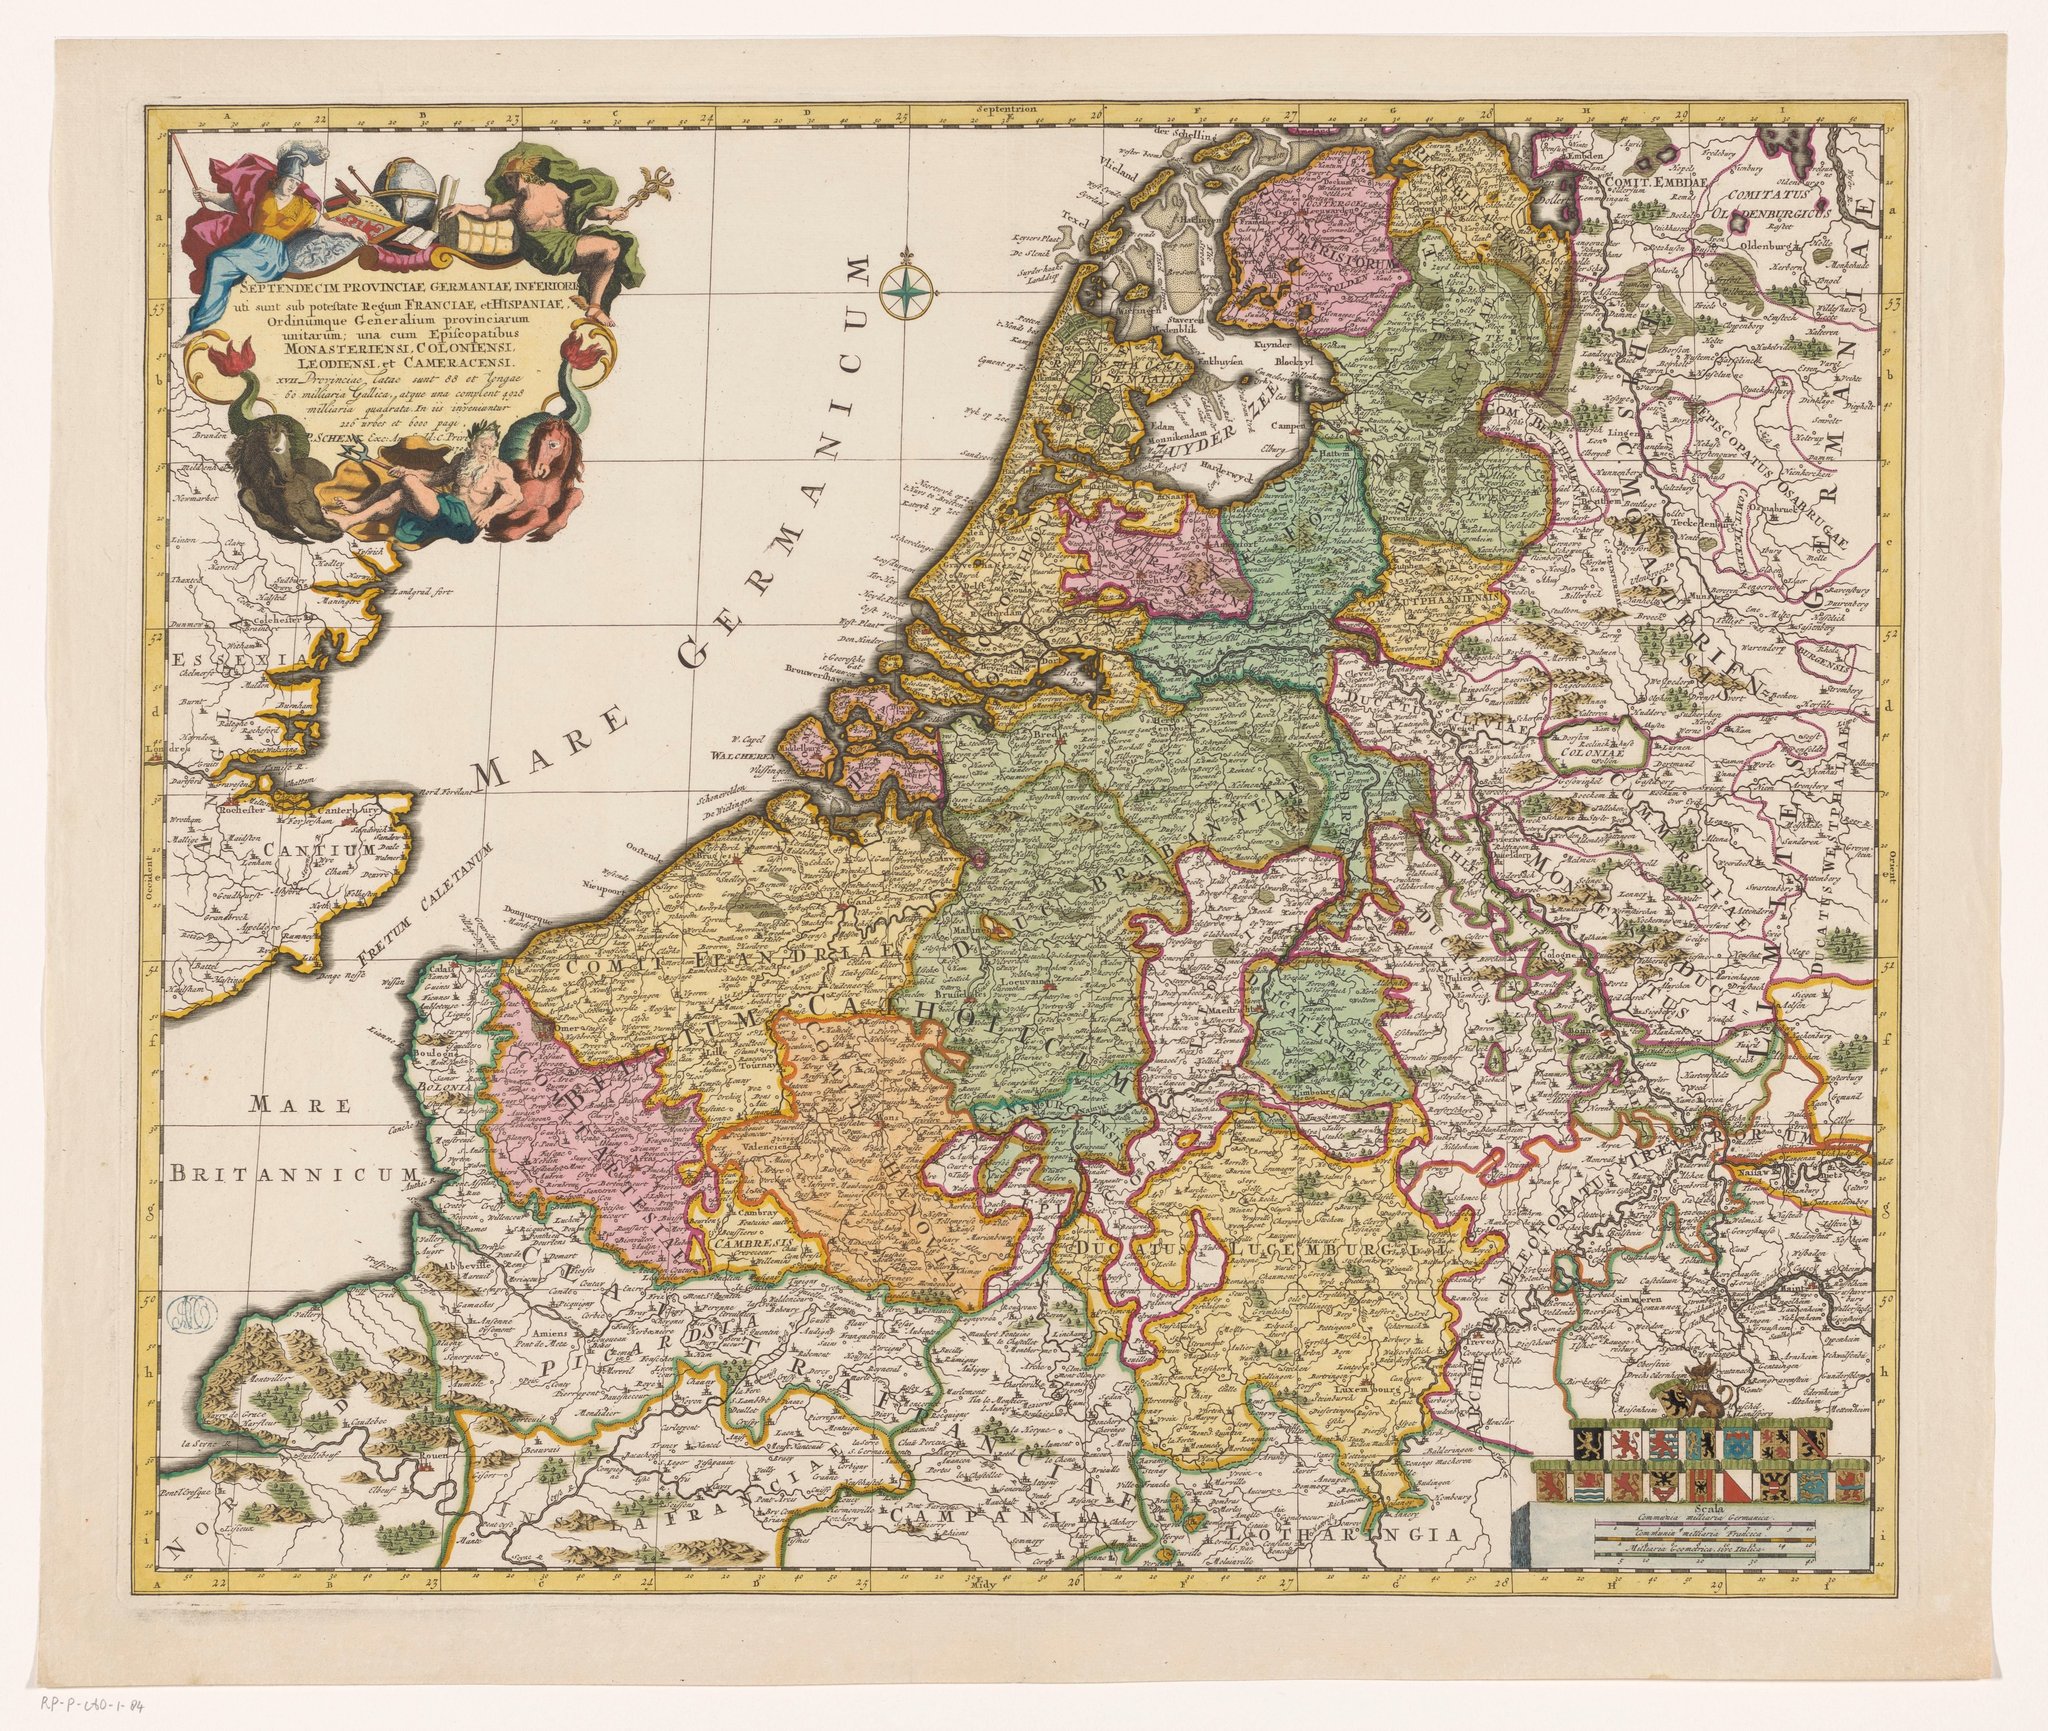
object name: print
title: Septendecim Provinciae Germaniae Inferioris …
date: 1704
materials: paper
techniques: engraving, etching, hand coloring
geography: amsterdam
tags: (story of) neptune (poseidon), coat of arms (as symbol of the state, etc.), maps of separate countries or regions, (story of) minerva (pallas, athena), (story of) mercury (hermes), bony fishes: hippocampus - ff - fabulous animals (sometimes wrongly called 'grotesques'); 'mostri' (ripa), low countries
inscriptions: collector's mark: Lugt 2228, collector's mark: Lugt 195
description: Links titelcartouche met daaromheen Minerva, Mercurius, Neptunus en twee zeepaarden. Rechtsonder schaalstok met daarop de wapens van de Zeventien Provinciën: Communia milliaria Germanica, Communia milliaria Francica, Milliaria geometrica sive Italica. De kaart is voorzien van een zoekrooster en een gradenverdeling langs de randen.